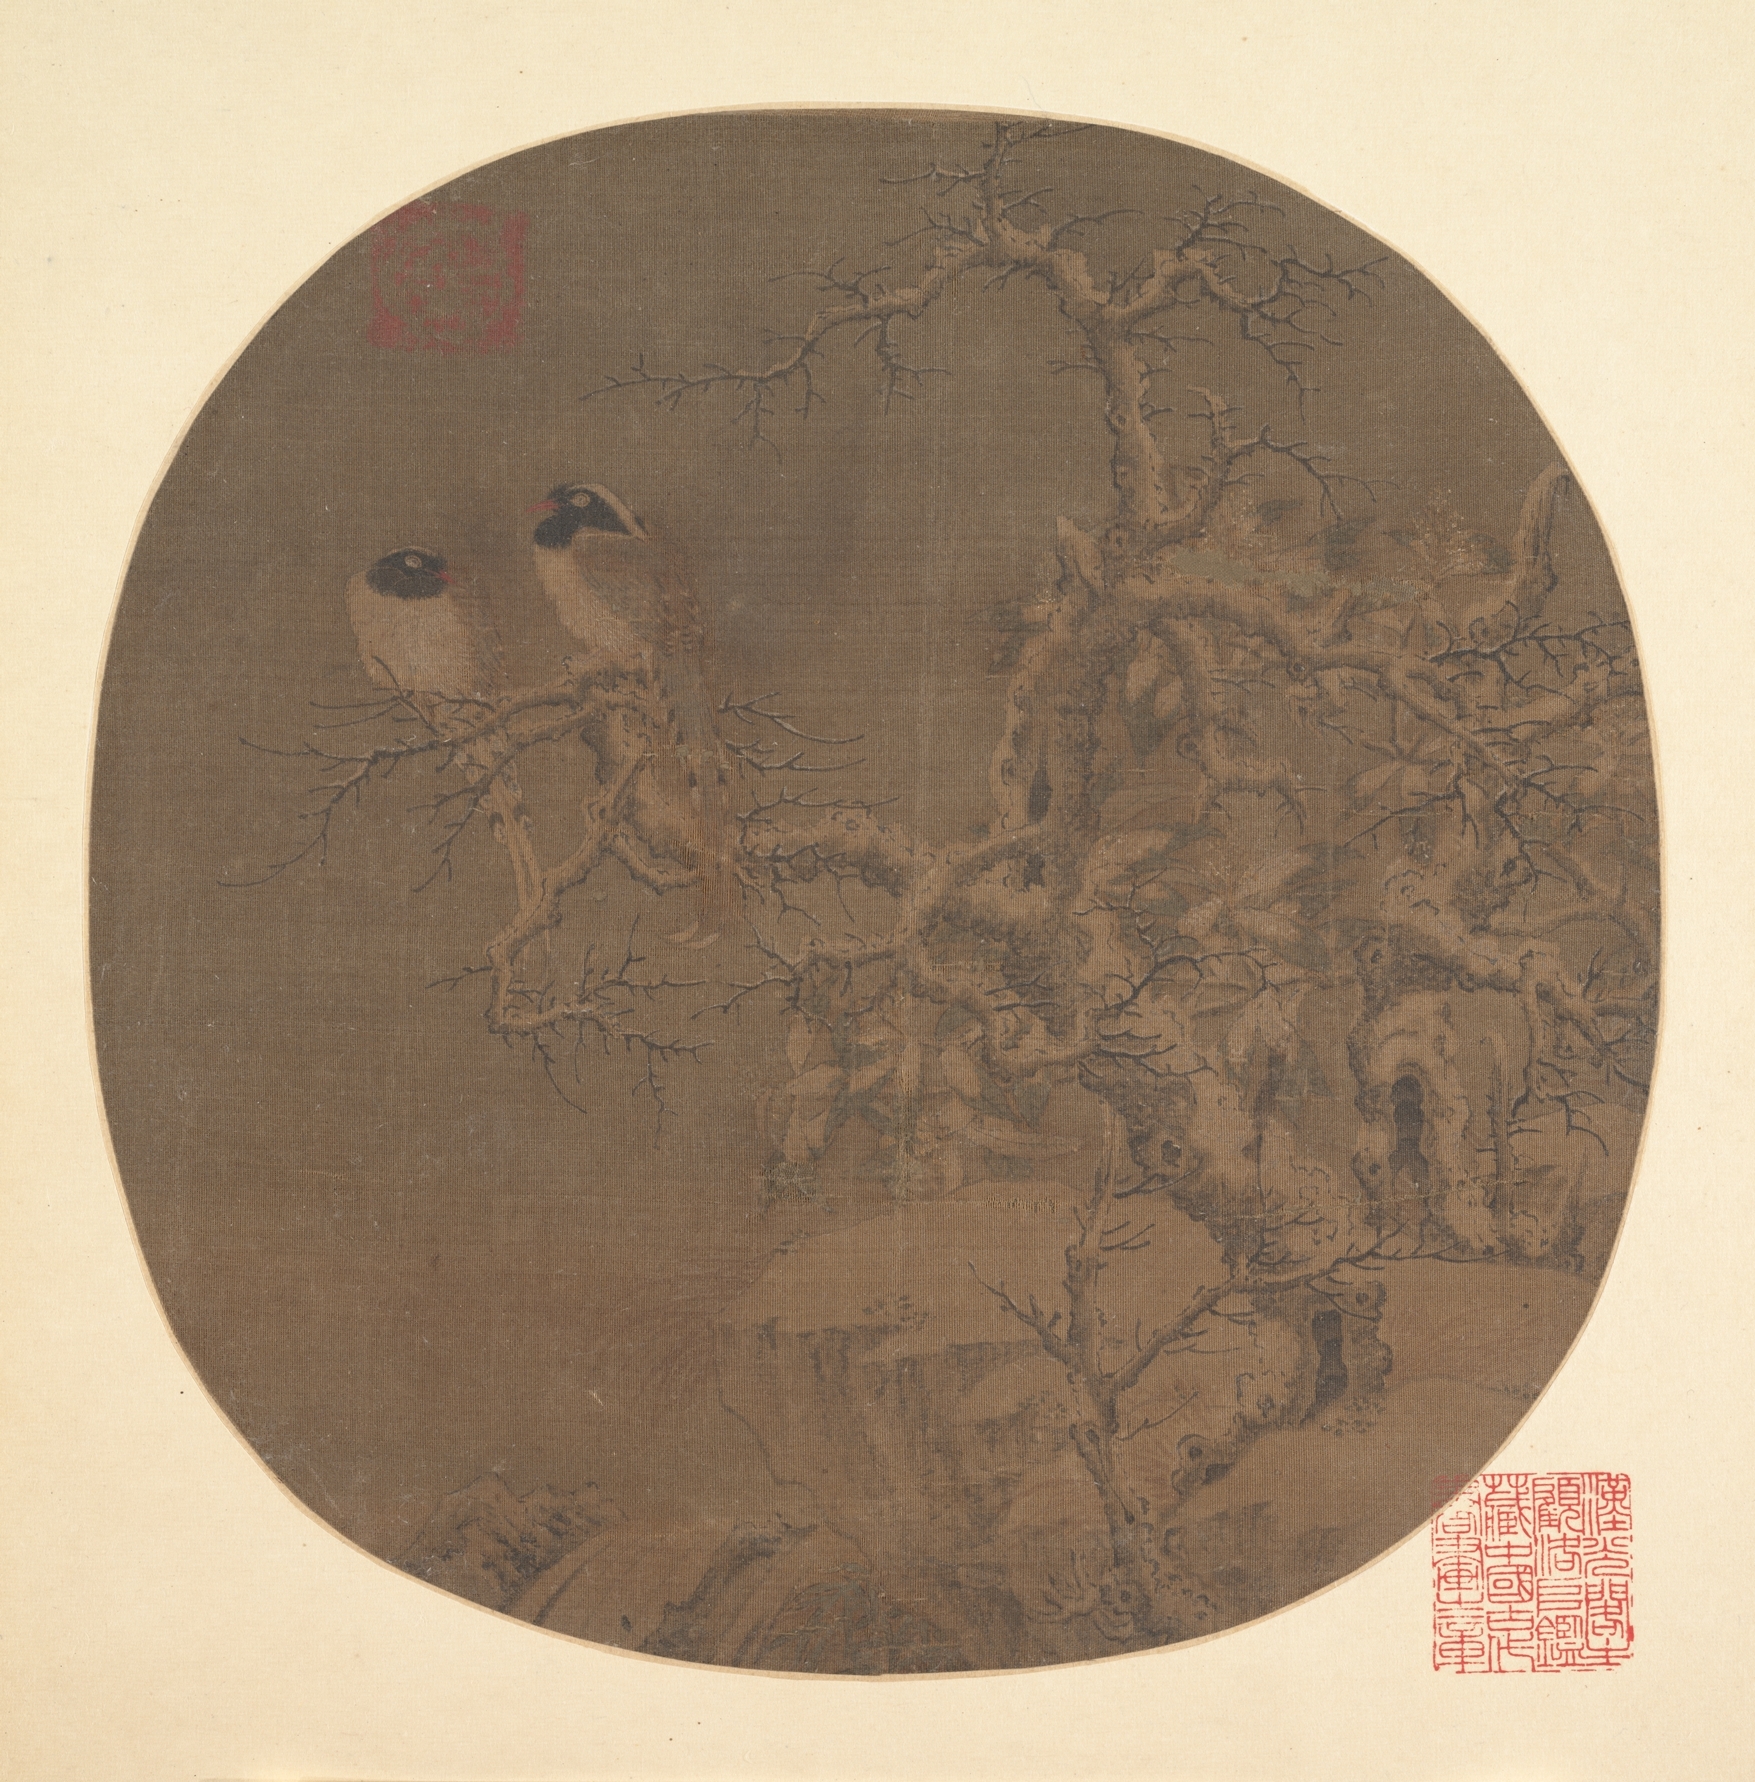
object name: fan mounted a an album leaf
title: Two Birds on a Wintry Tree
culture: chinese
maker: unidentified artist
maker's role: artist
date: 1201-1300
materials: ink, silk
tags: birds,trees,snow